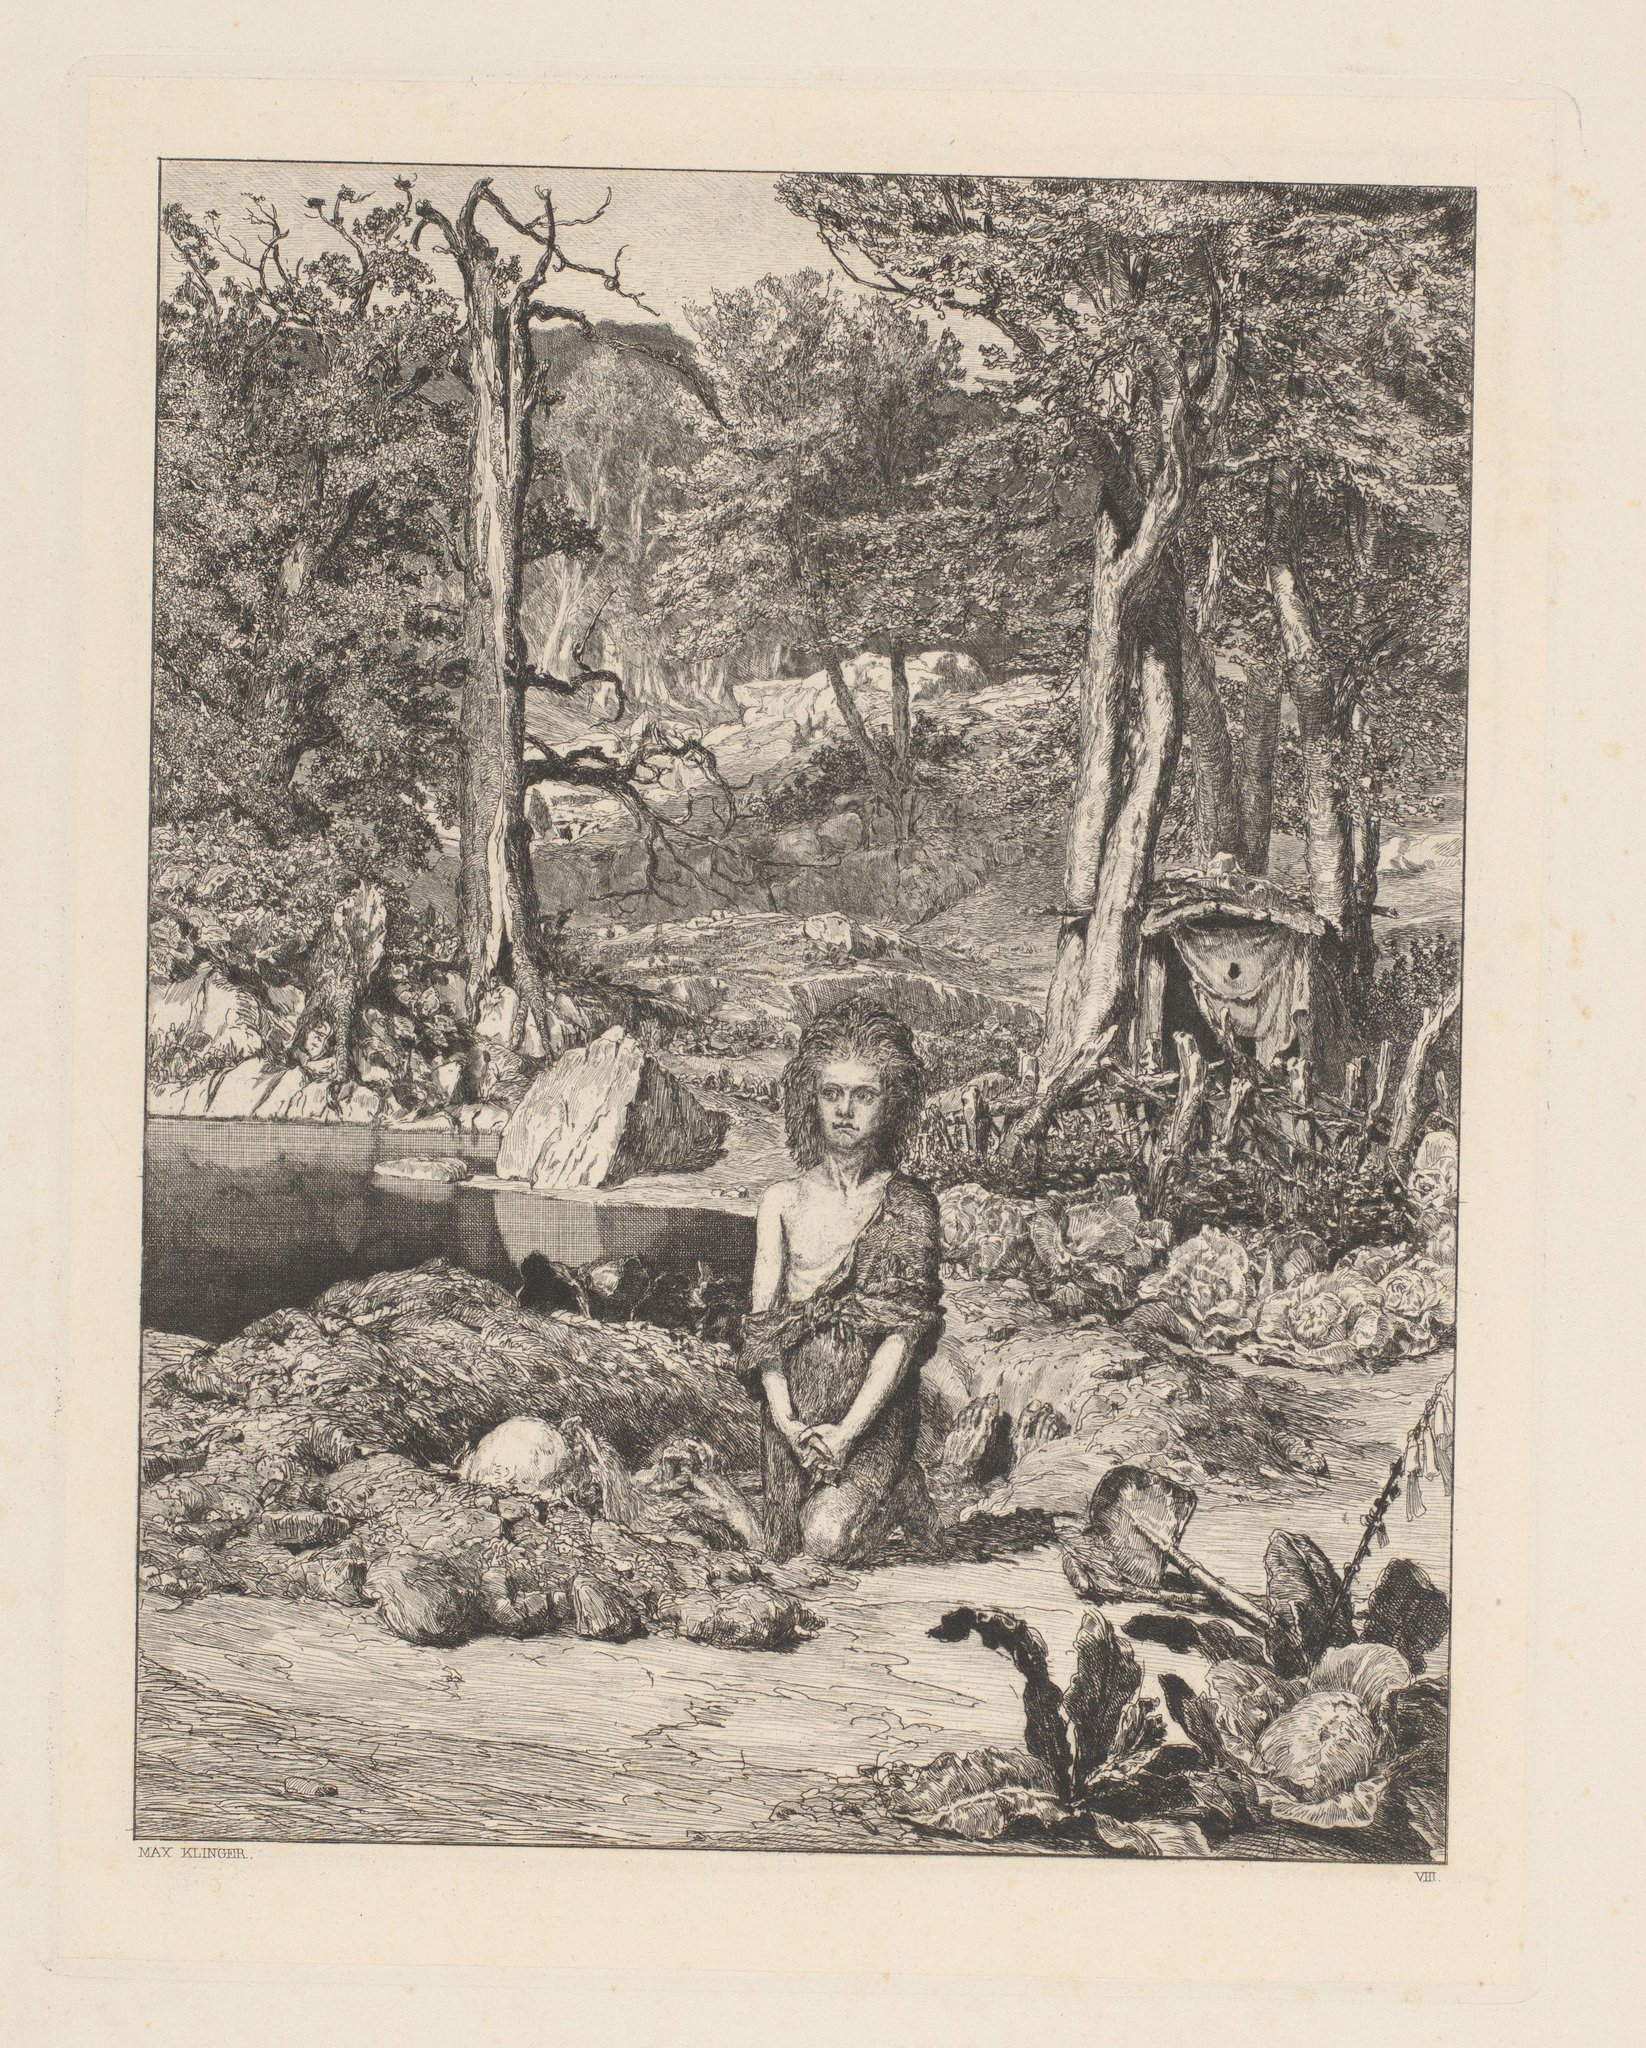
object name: print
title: Intermezzi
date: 1881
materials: paper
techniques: aquatint, etching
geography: nuremberg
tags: burial, anchorite, hermit, mourning the dead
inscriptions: collector's mark: Lugt 2228